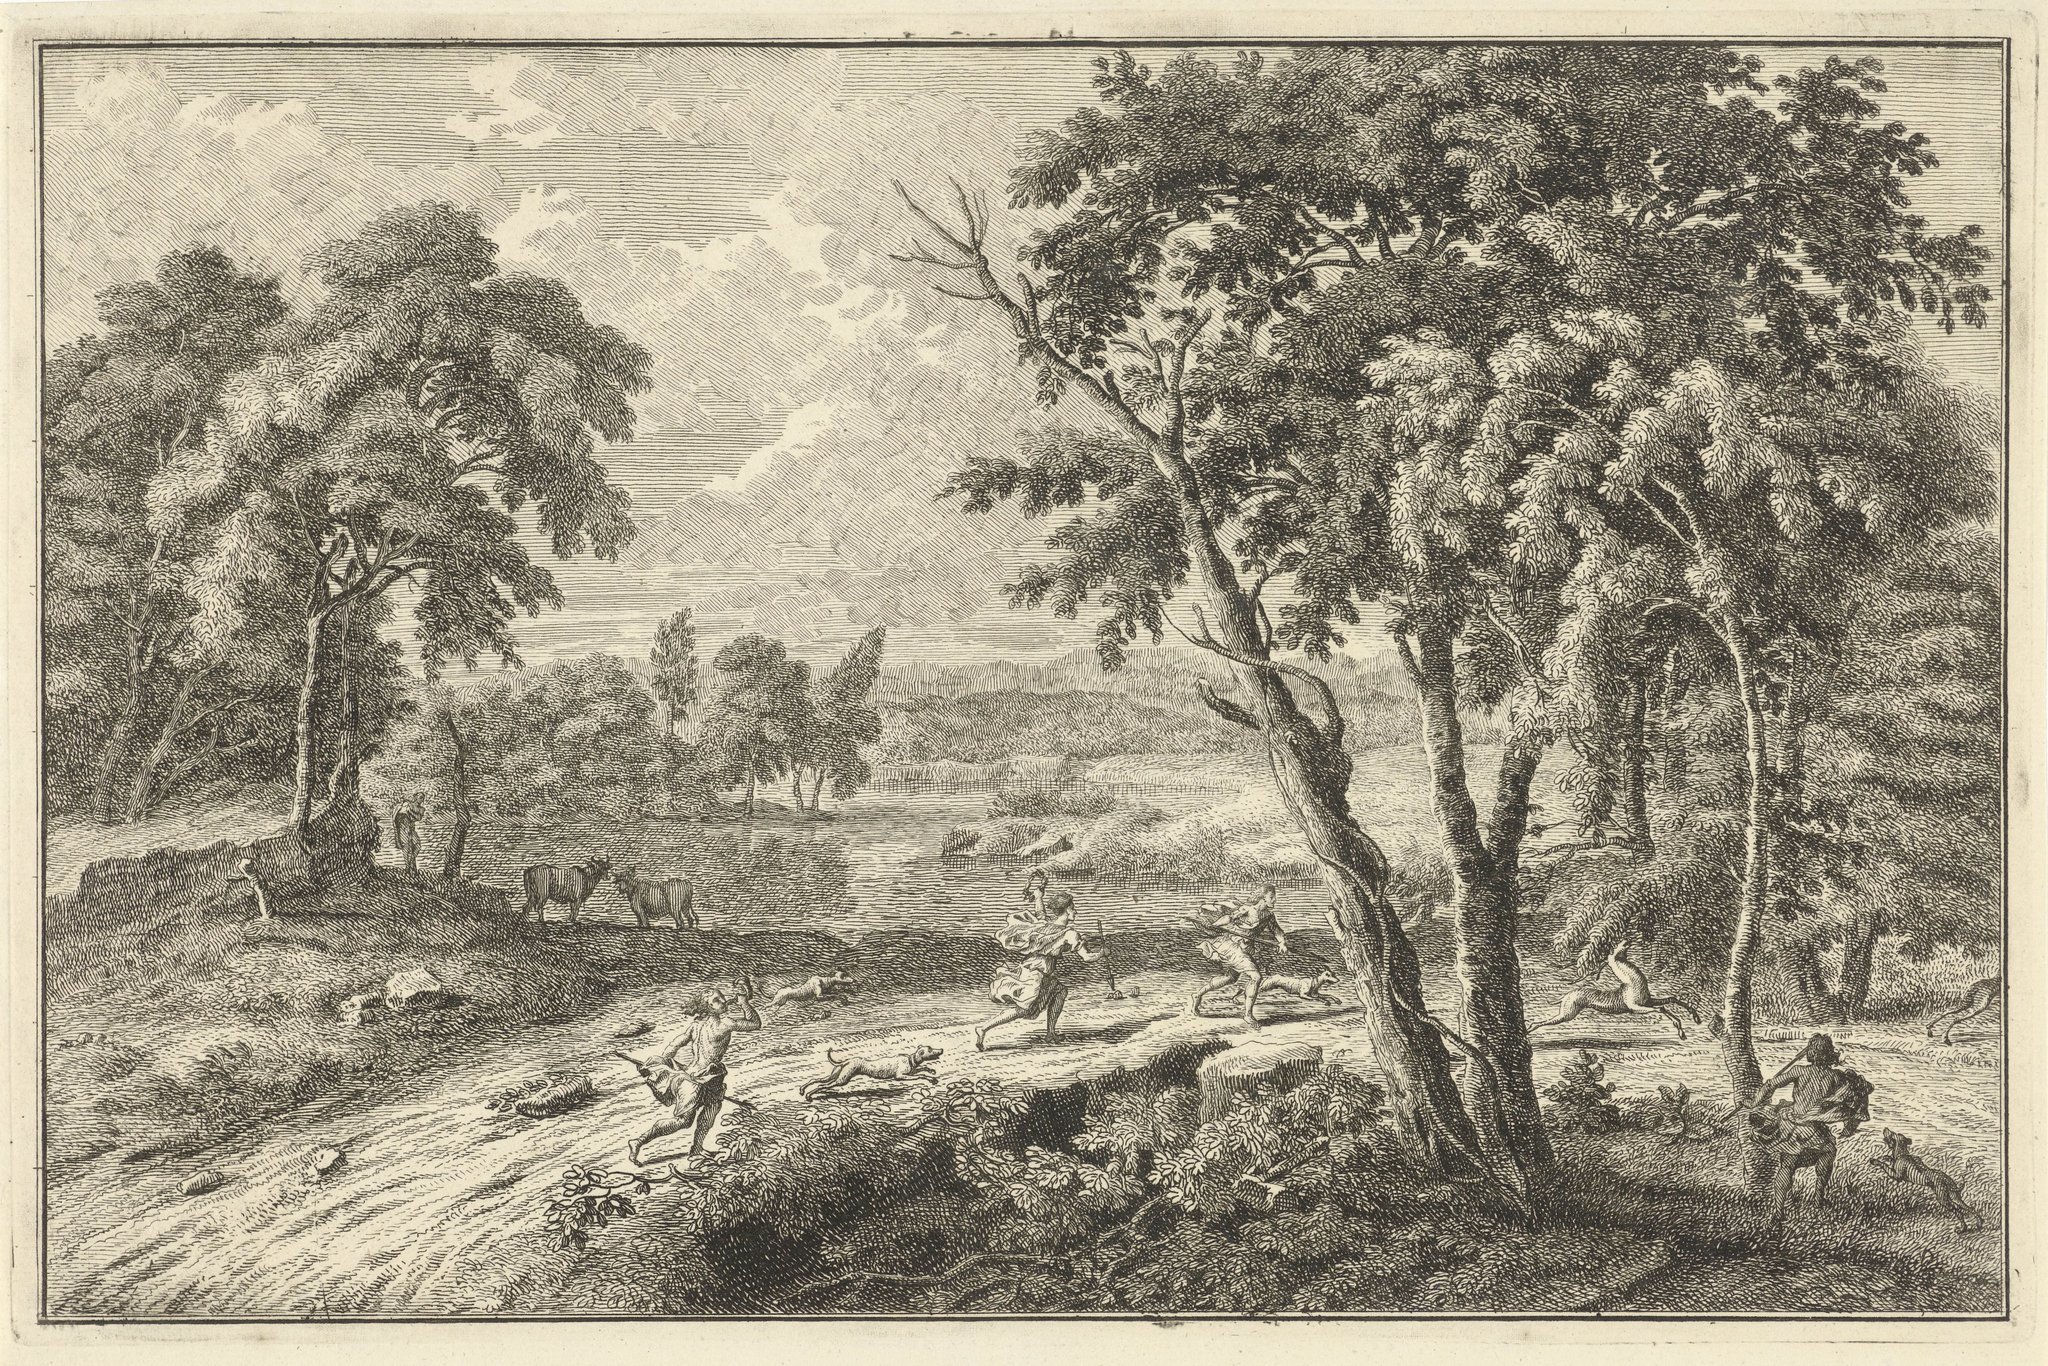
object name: print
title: Italiaanse en Duitse landschappen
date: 1710-1747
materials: paper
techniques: etching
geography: amsterdam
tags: hoofed animals: deer, hunter, landscapes with waters, waterscapes, seascapes (in the temperate zone)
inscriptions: collector's mark: Lugt 240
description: Arcadisch rivierlandschap met jagers en honden die herten achterna jagen. Op de achtergrond staan twee koeien op de oever. De prent maakt deel uit van een 40-delige serie prenten met voorstellingen van Italiaanse en Duitse landschappen.